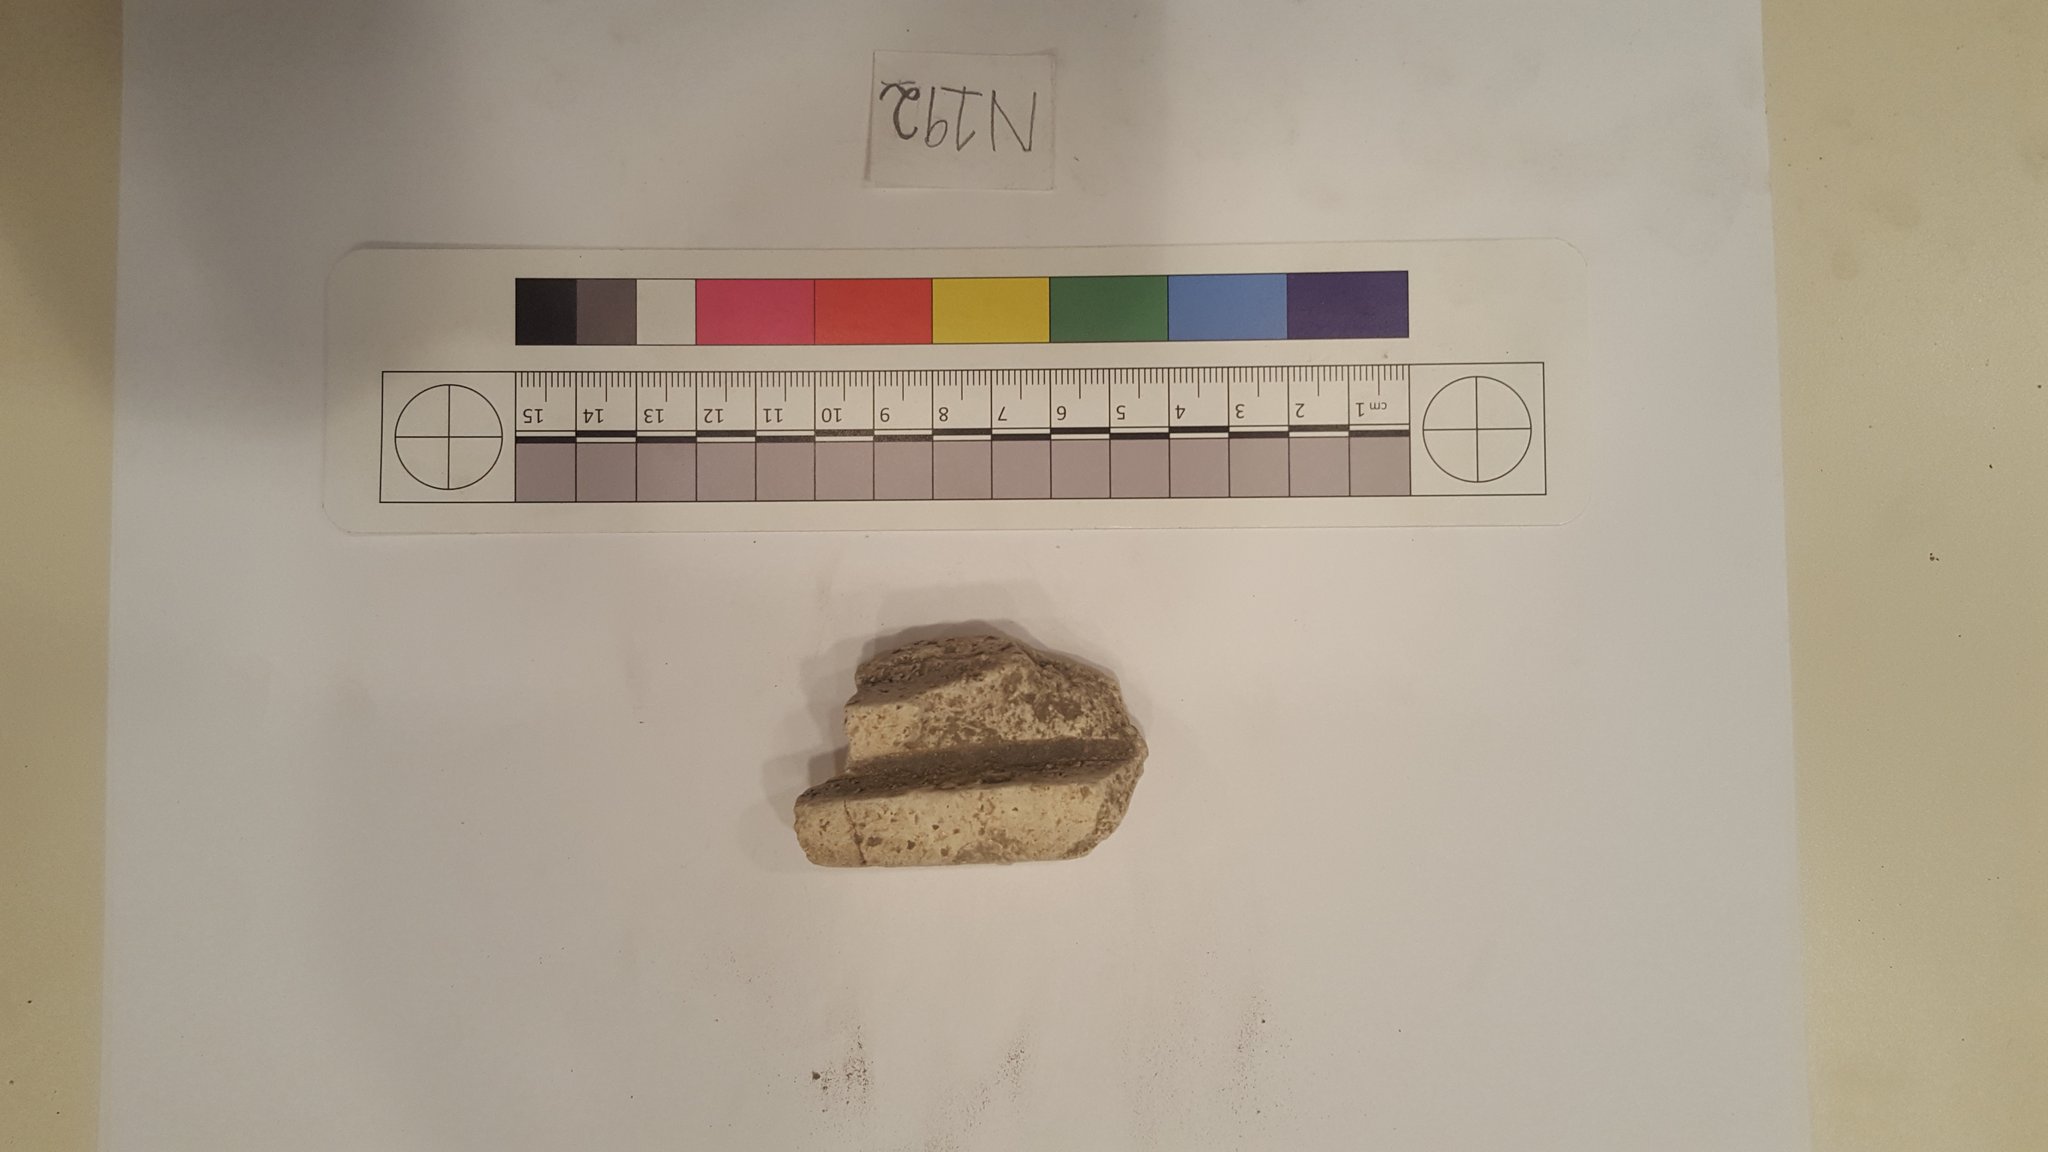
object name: fragment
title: Stucco Fragment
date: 701-1200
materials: plaster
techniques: carving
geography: iran